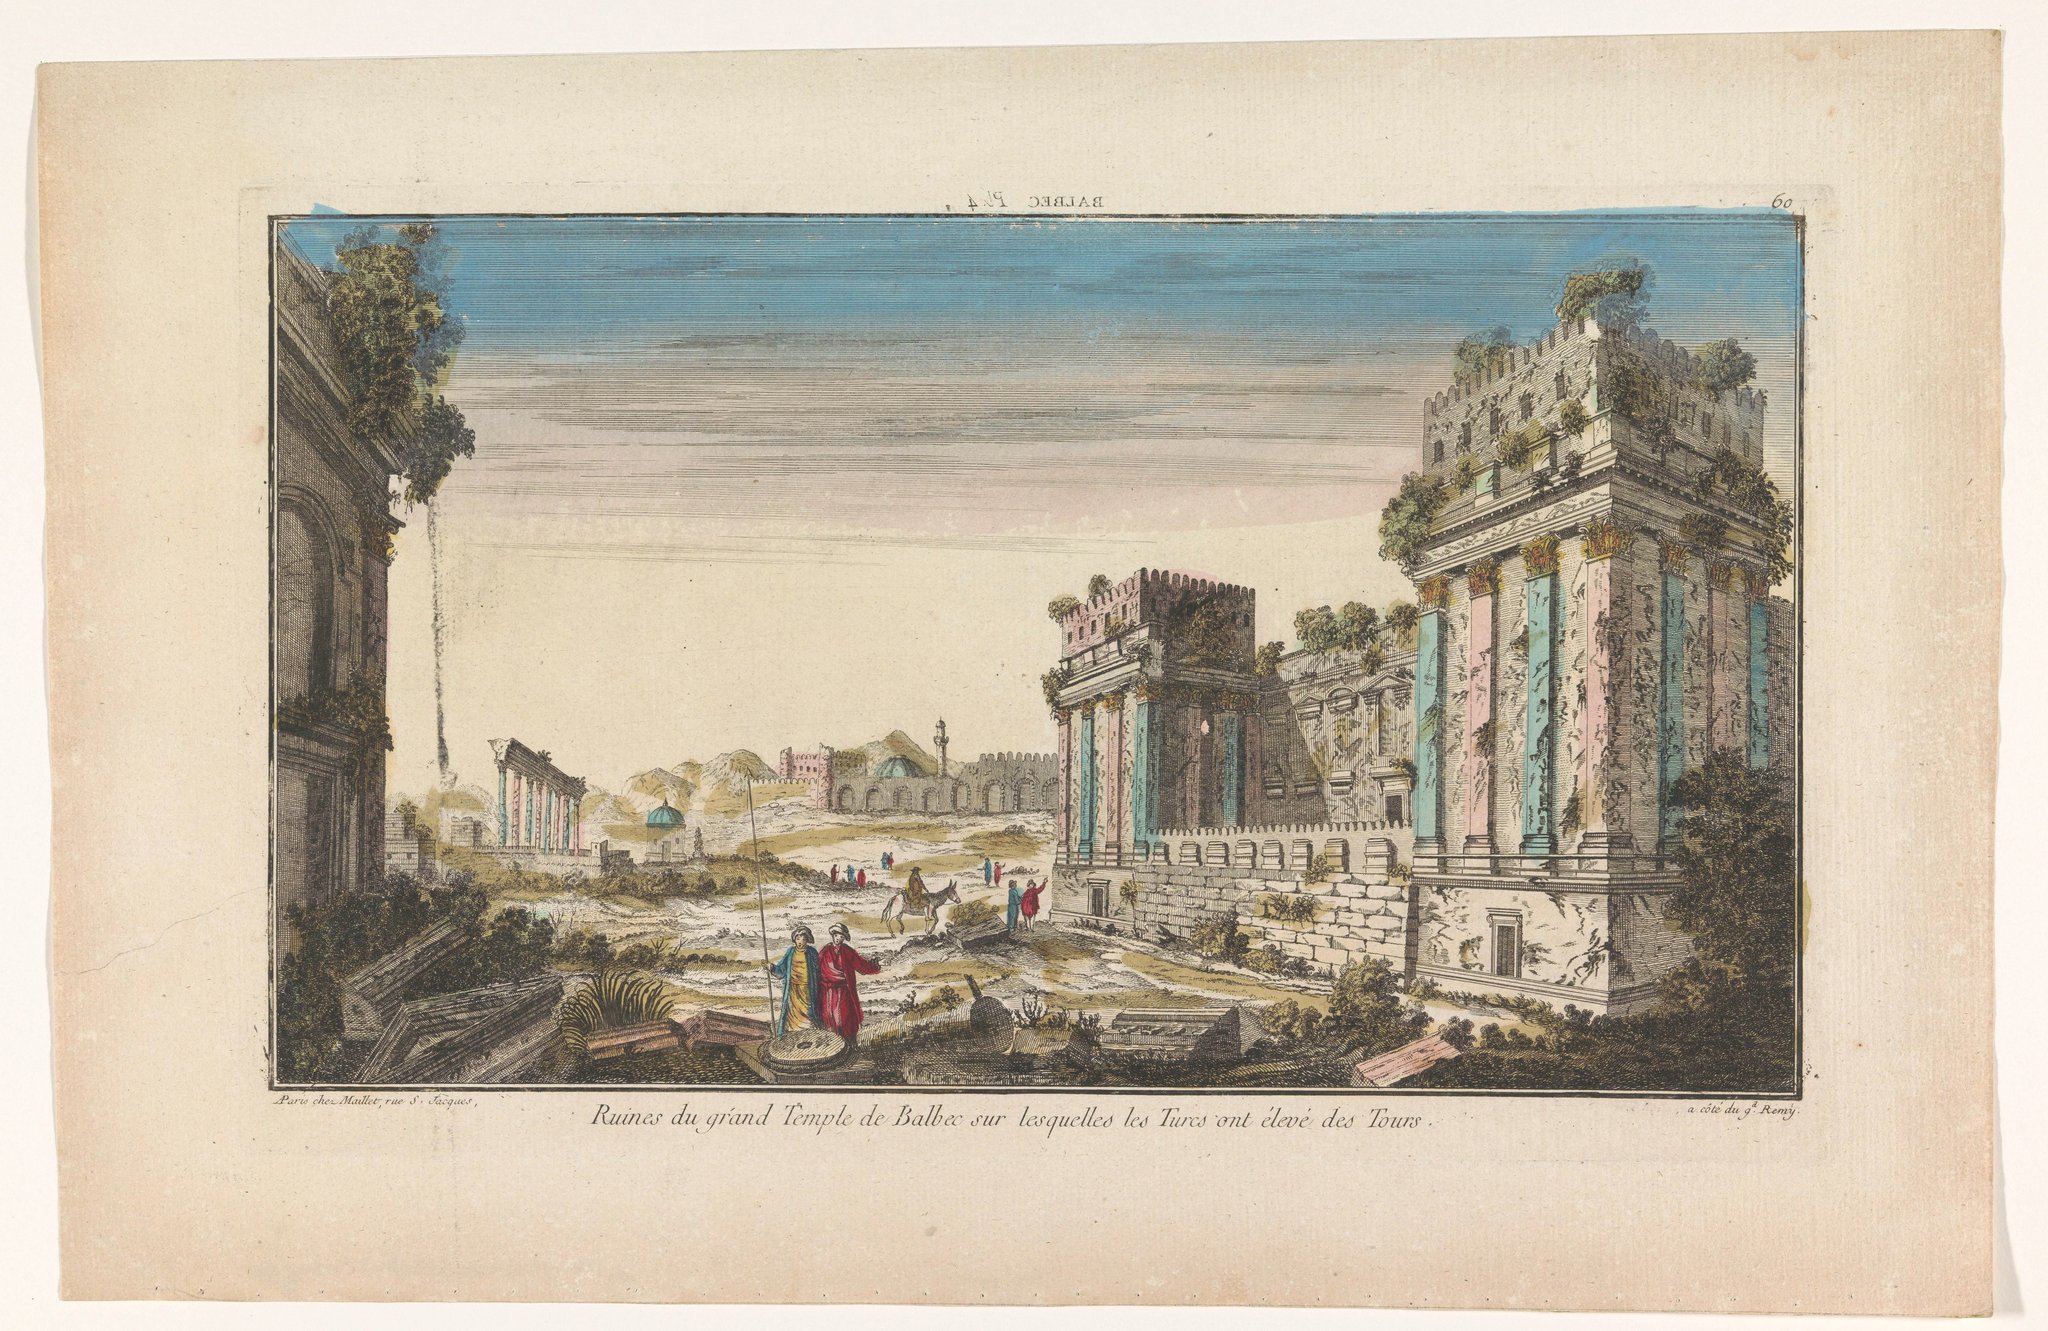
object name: opticaprent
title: Gezicht op de ruïnes van het tempelcomplex te Baalbek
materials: paper, watercolor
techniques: brush, etching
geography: paris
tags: temple, shrine ~ roman religion, landscape with ruins (+ city(-scape) with figures, staffage)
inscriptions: collector's mark: Lugt 2166, watermark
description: In de titel genummerd: 4. Rechtsboven genummerd: 60.